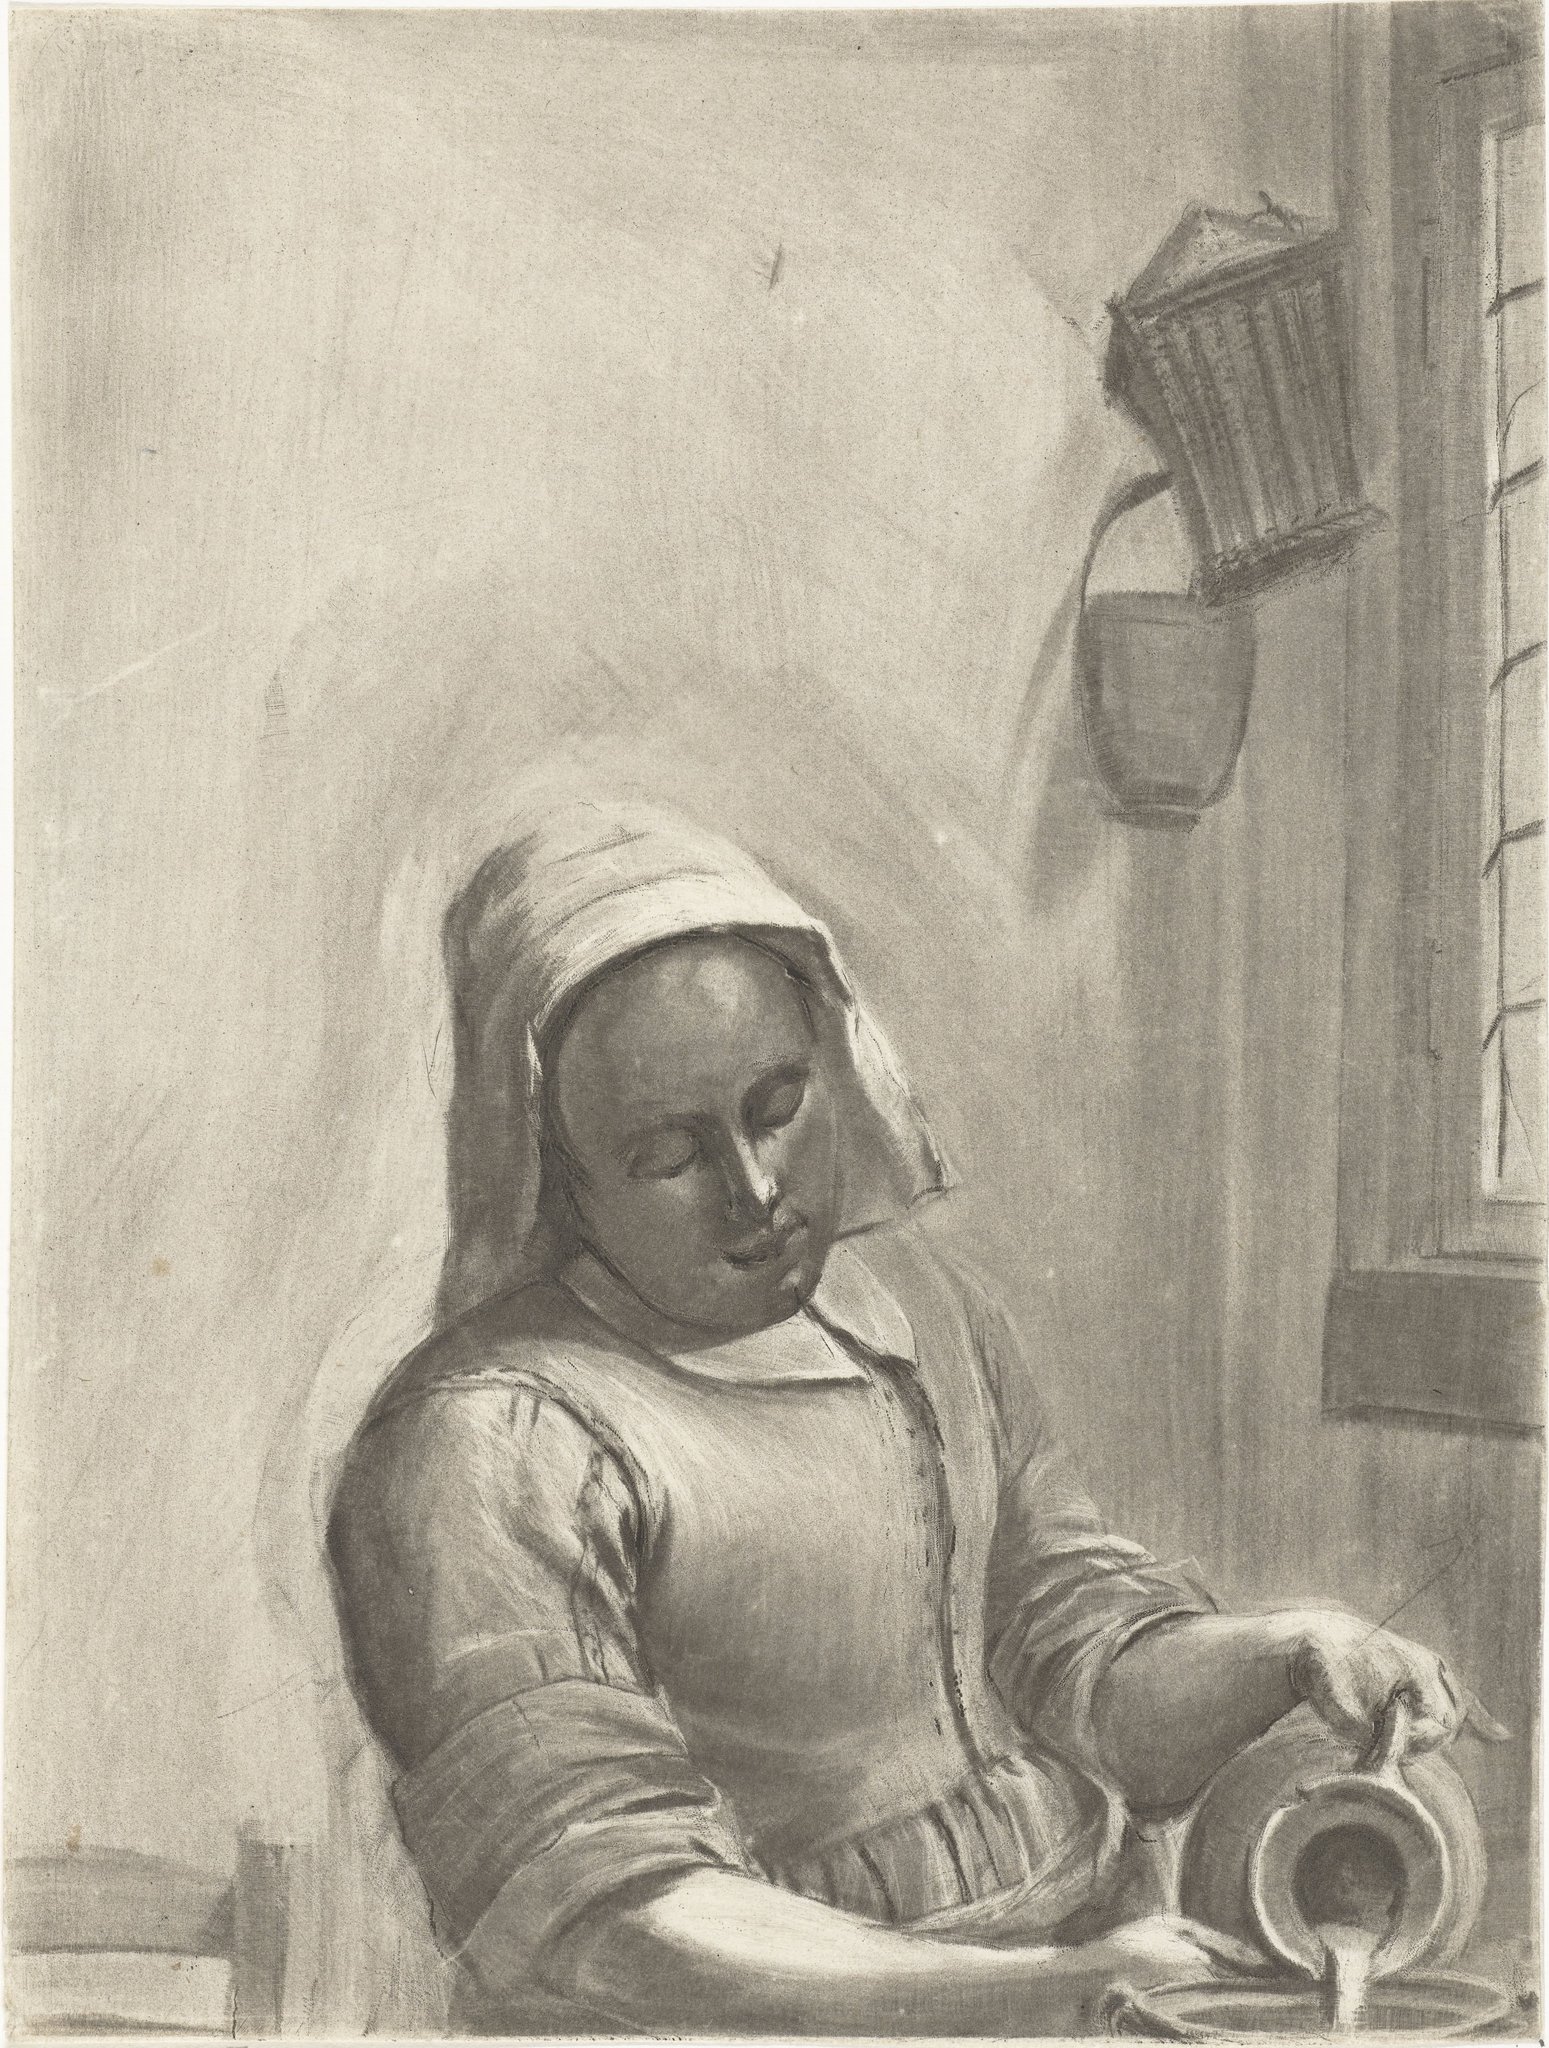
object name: print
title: Het melkmeisje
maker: jurriaan cootwijck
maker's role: print maker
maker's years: 1714-1798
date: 1724-1798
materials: paper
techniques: print drawing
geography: amsterdam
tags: milk, milkmaid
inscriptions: collector's mark: Lugt 2228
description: Een dienstmaagd staat achter een tafel en schenkt melk uit een kruik in een kom. Rechts een venster.